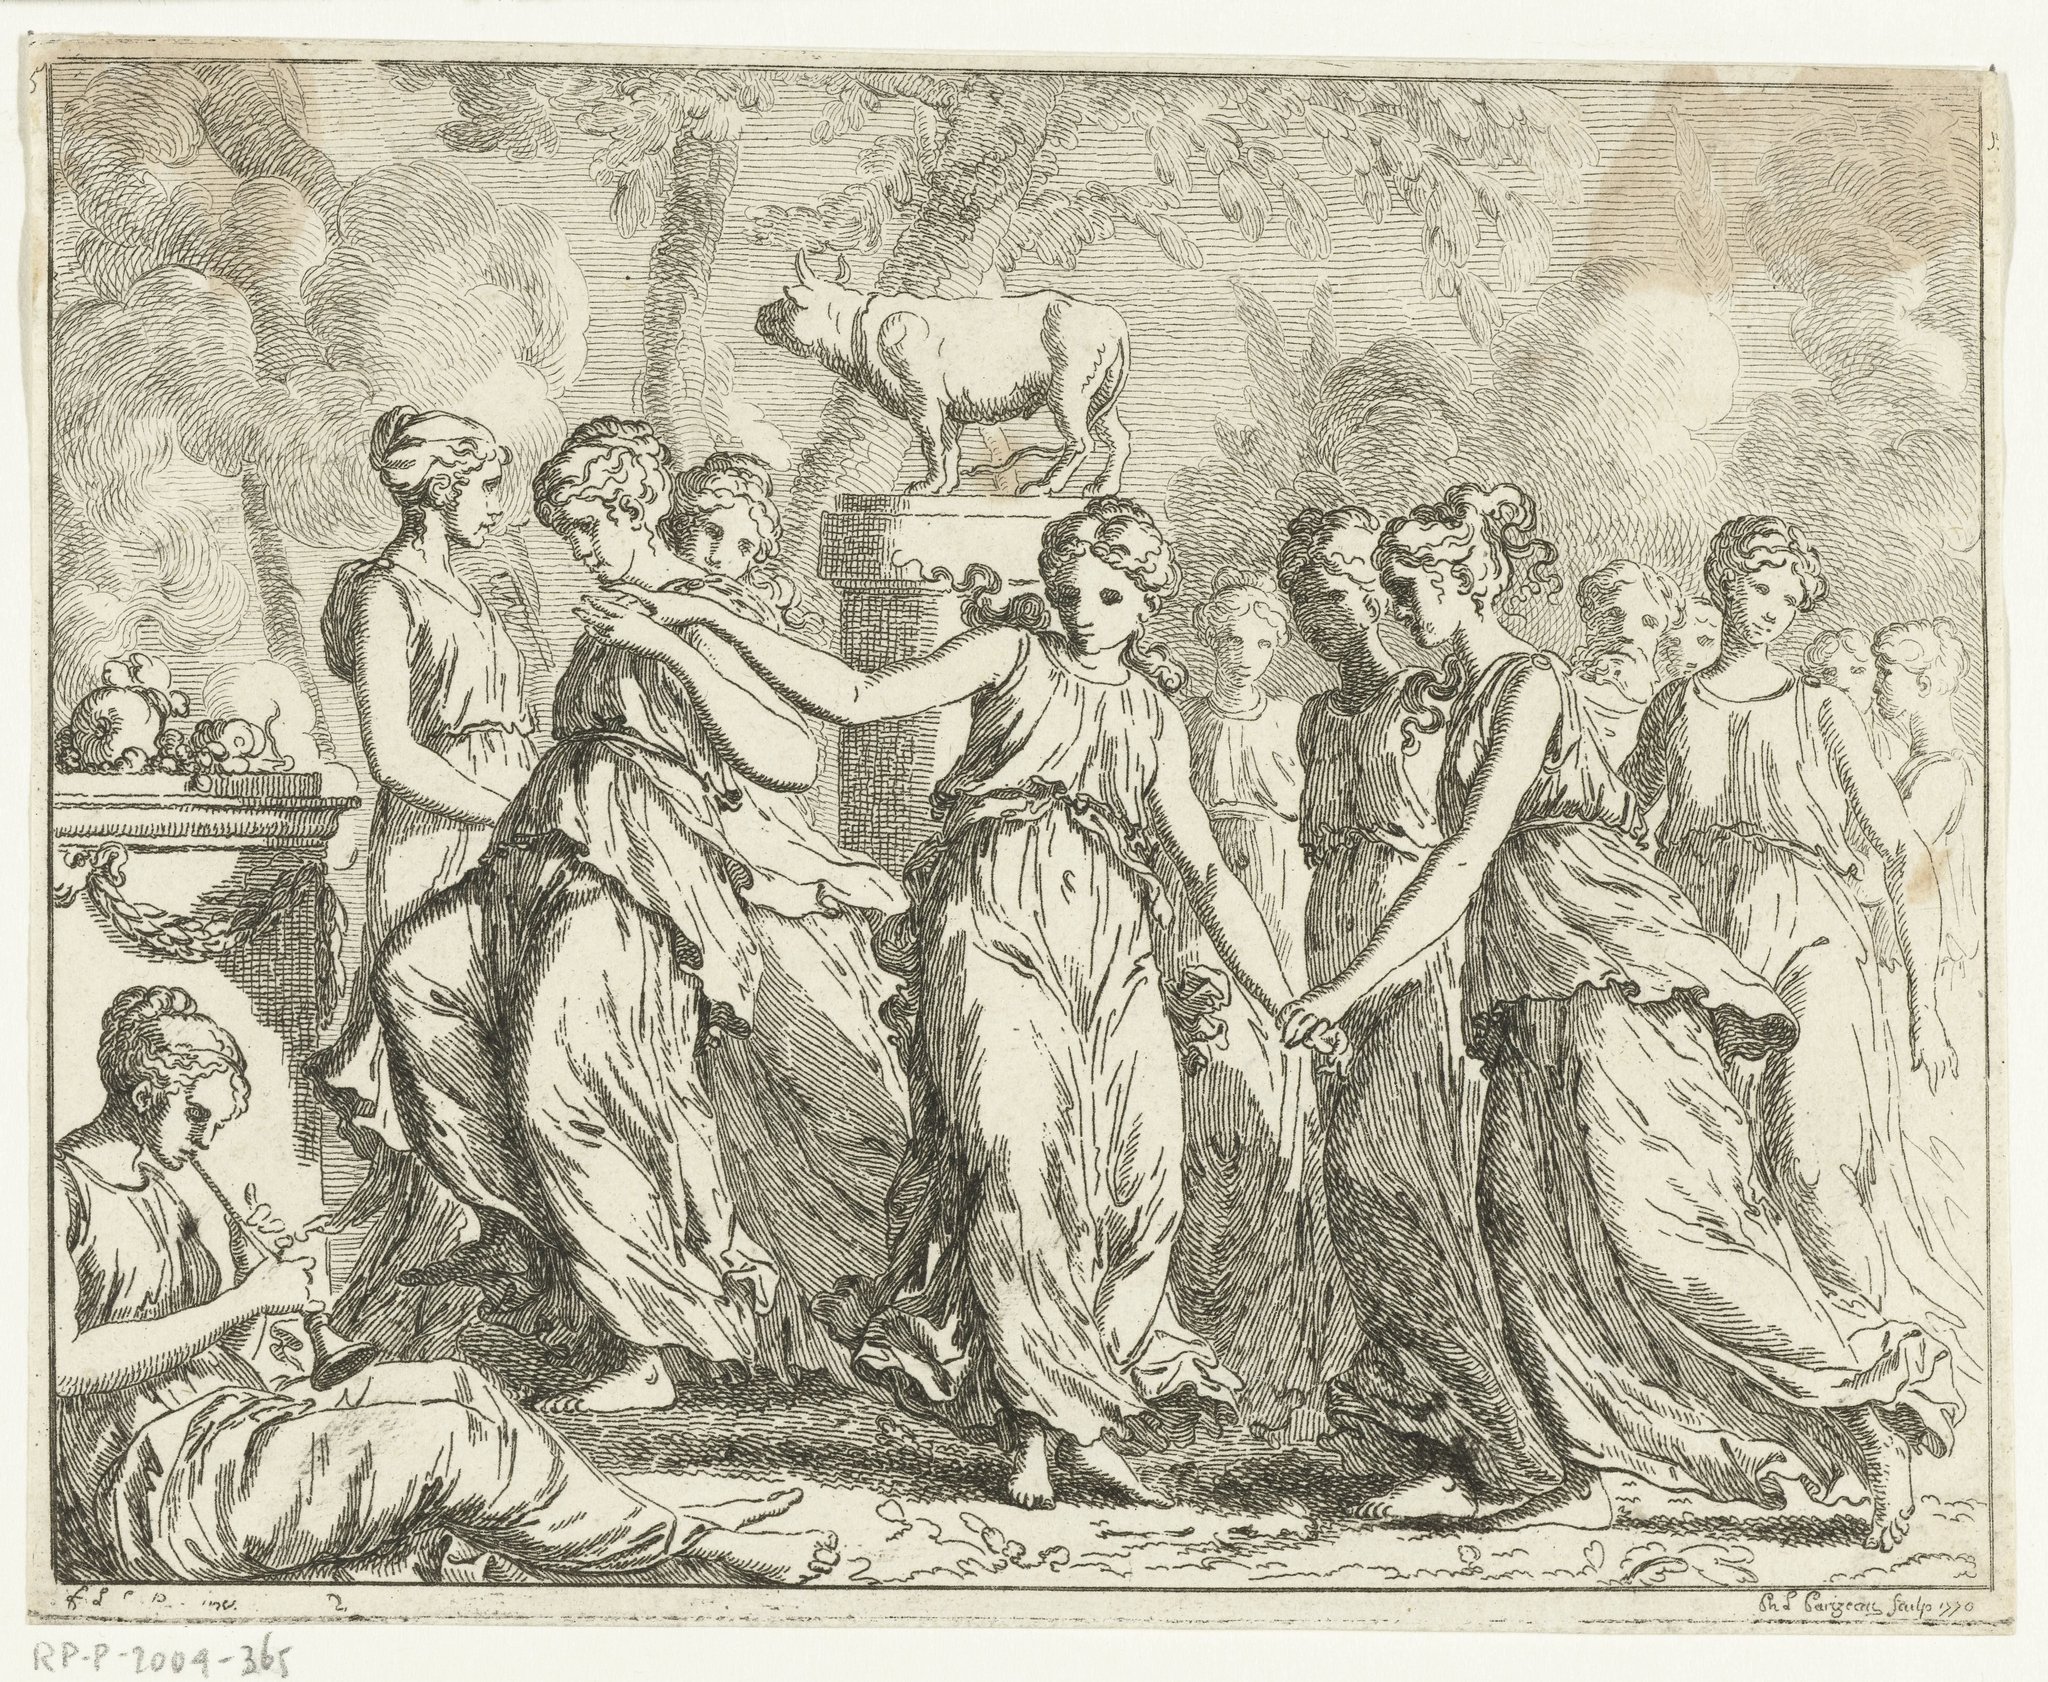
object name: print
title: Dans rond een beeld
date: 1770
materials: paper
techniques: etching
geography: france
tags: ritual music and dancing ~ non-christian religions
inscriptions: collector's mark: Lugt 2228, collector's mark: Lugt 2760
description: Een groep nimfen danst in een kring om het beeld van een rund op een sokkel. Linksvoor speelt een nimf op een schalmei.